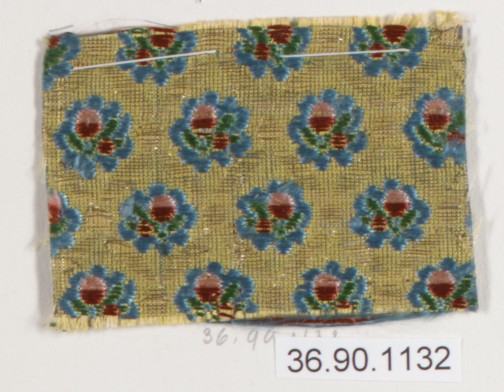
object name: sample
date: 1701-1900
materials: metal thread, silk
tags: flowers